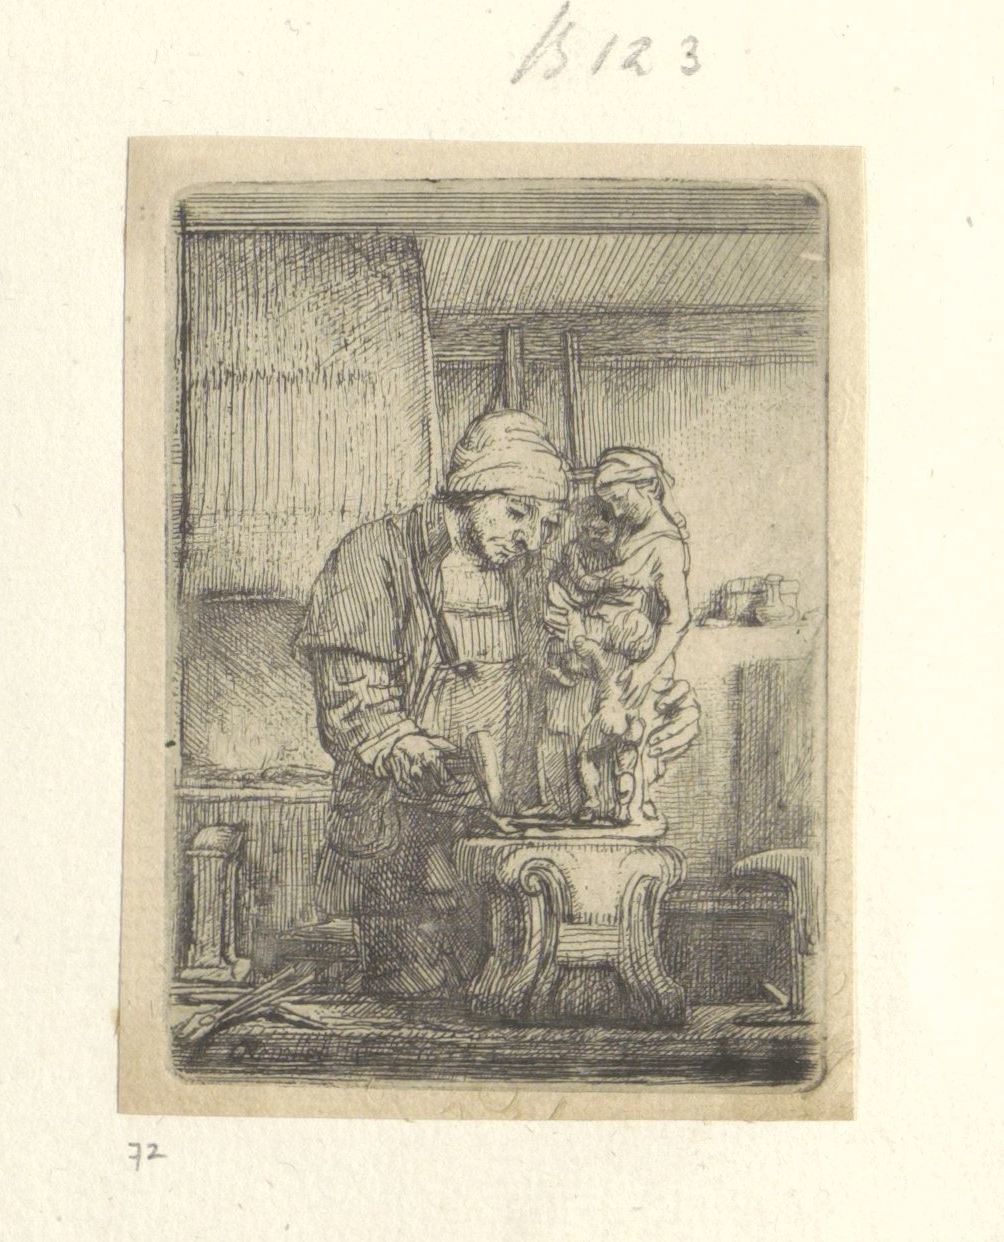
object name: print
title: Goudsmid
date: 1655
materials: paper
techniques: drypoint, etching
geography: paris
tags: jeweller, goldsmith, silversmith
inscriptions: date